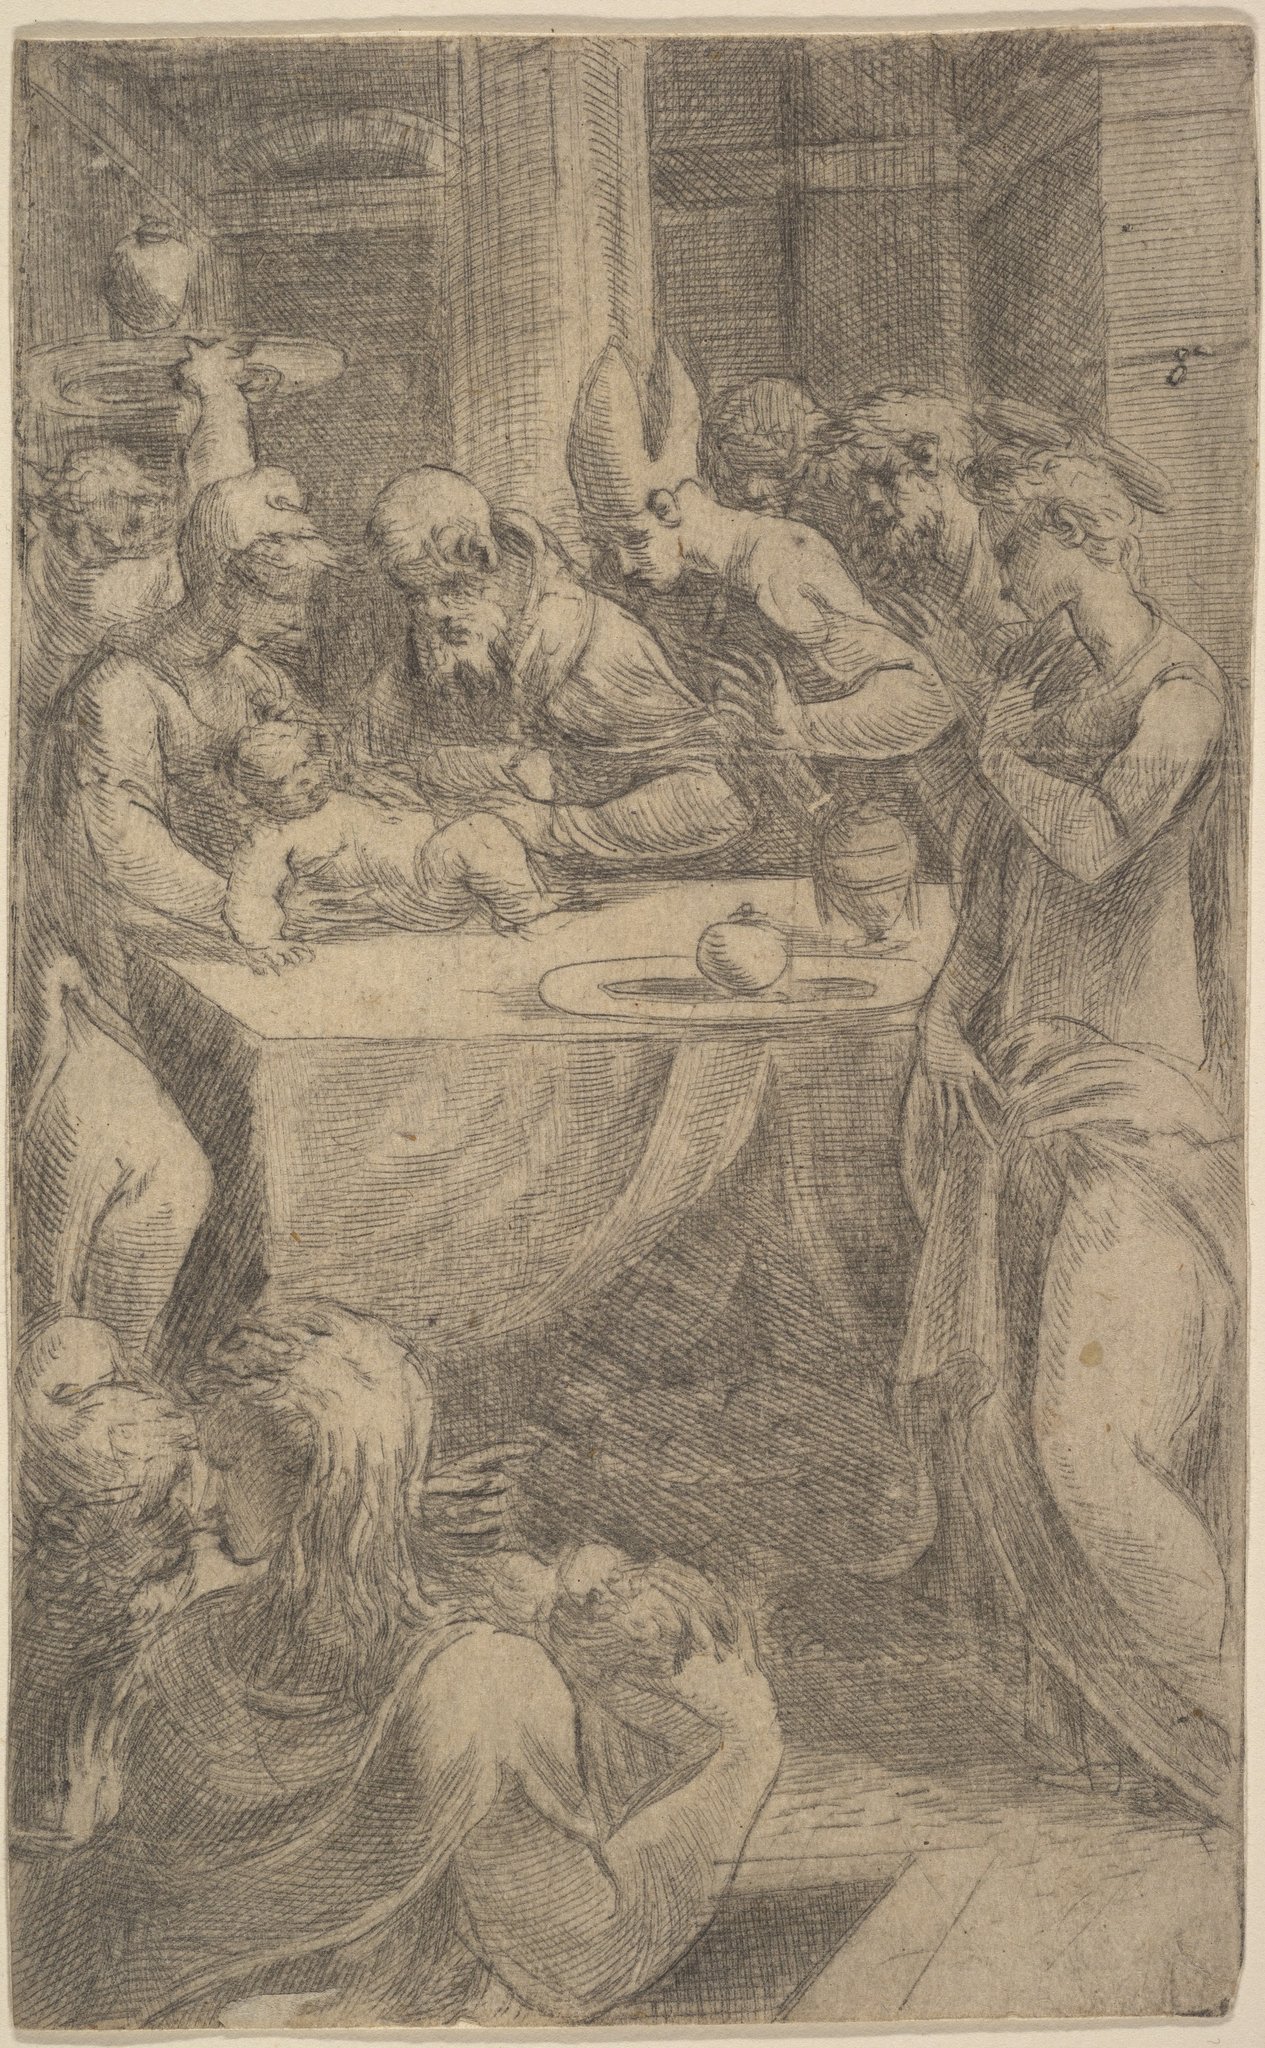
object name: print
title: The Circumcision of Christ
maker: andrea schiavone (andrea meldola)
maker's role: artist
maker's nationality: italian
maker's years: 1510-1563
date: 1542-1546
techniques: etching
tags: men,women,jesus,circumcision